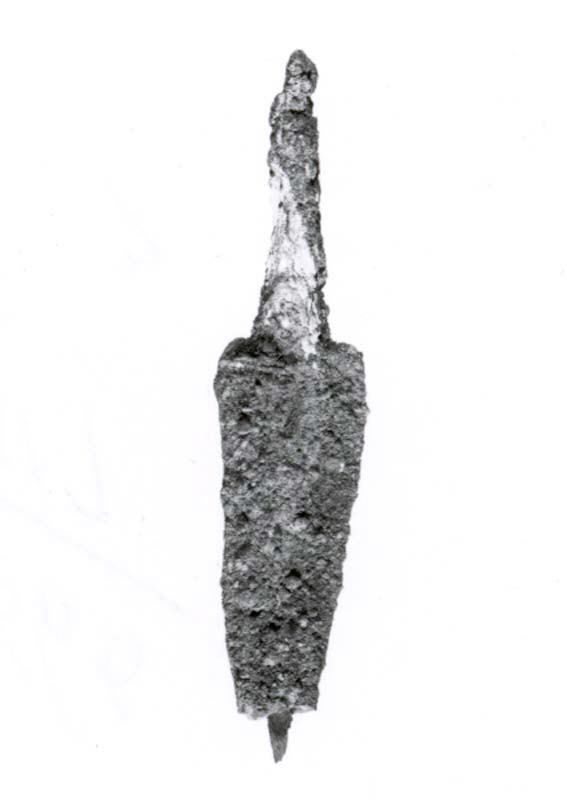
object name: arrowhead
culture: iranian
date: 900-801 BCE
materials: iron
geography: iran